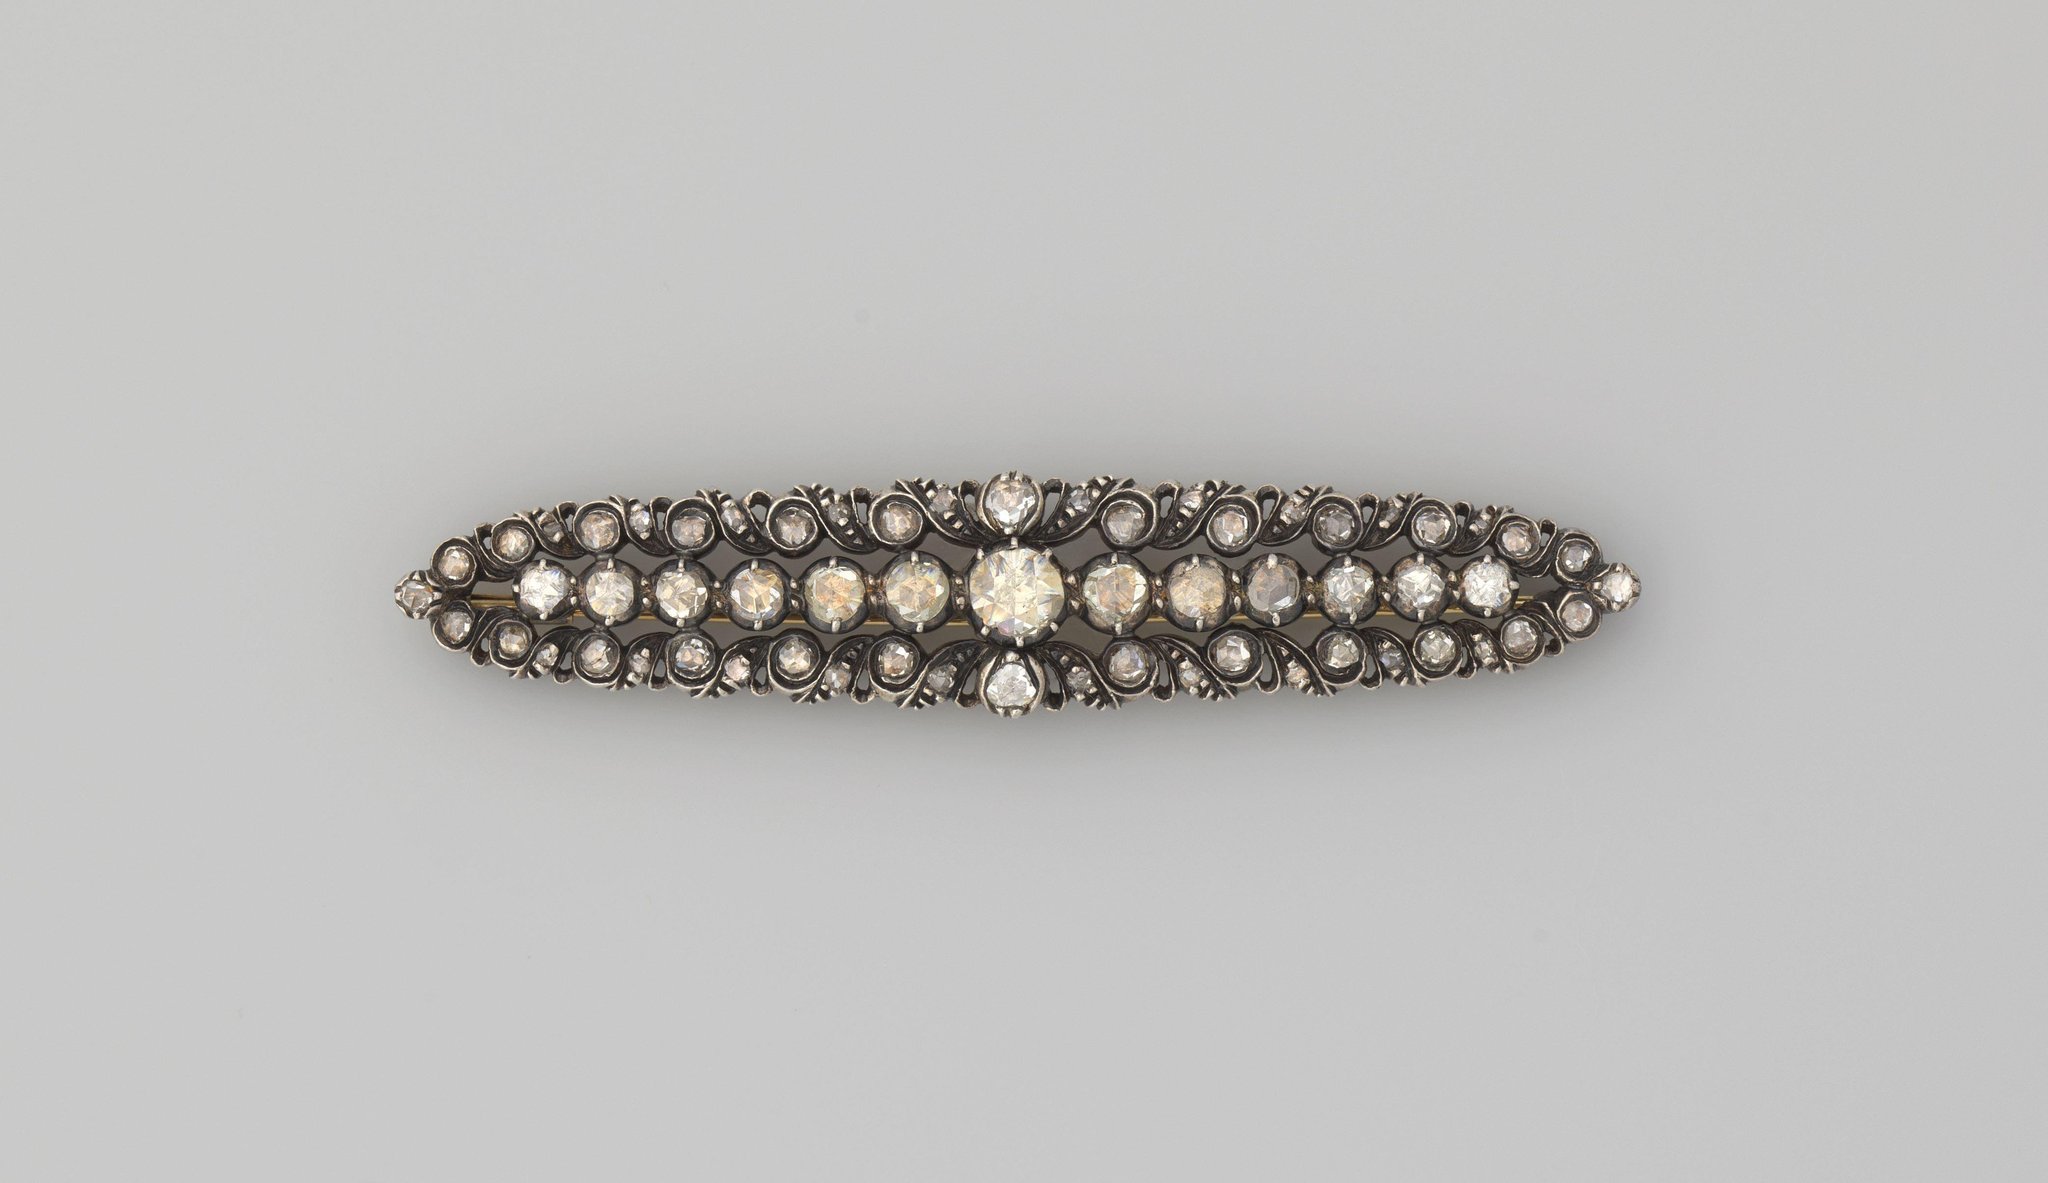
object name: brooch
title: Brochette van zilver en goud met diamanten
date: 1912-1925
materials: diamond, gold, silver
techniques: engraving, faceting, grinding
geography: hoorn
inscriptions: maker's mark: ‘JM.’, duty mark: ‘I’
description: Brochette van zilver en goud met 41 roosgeslepen diamanten, waartussen kleine gefacetteerde diamanten, voorzien van een kanonsluiting. De bovenzijde is van zilver, de onderzijde van goud. De achterzijde is voorzien van florale graveringen.